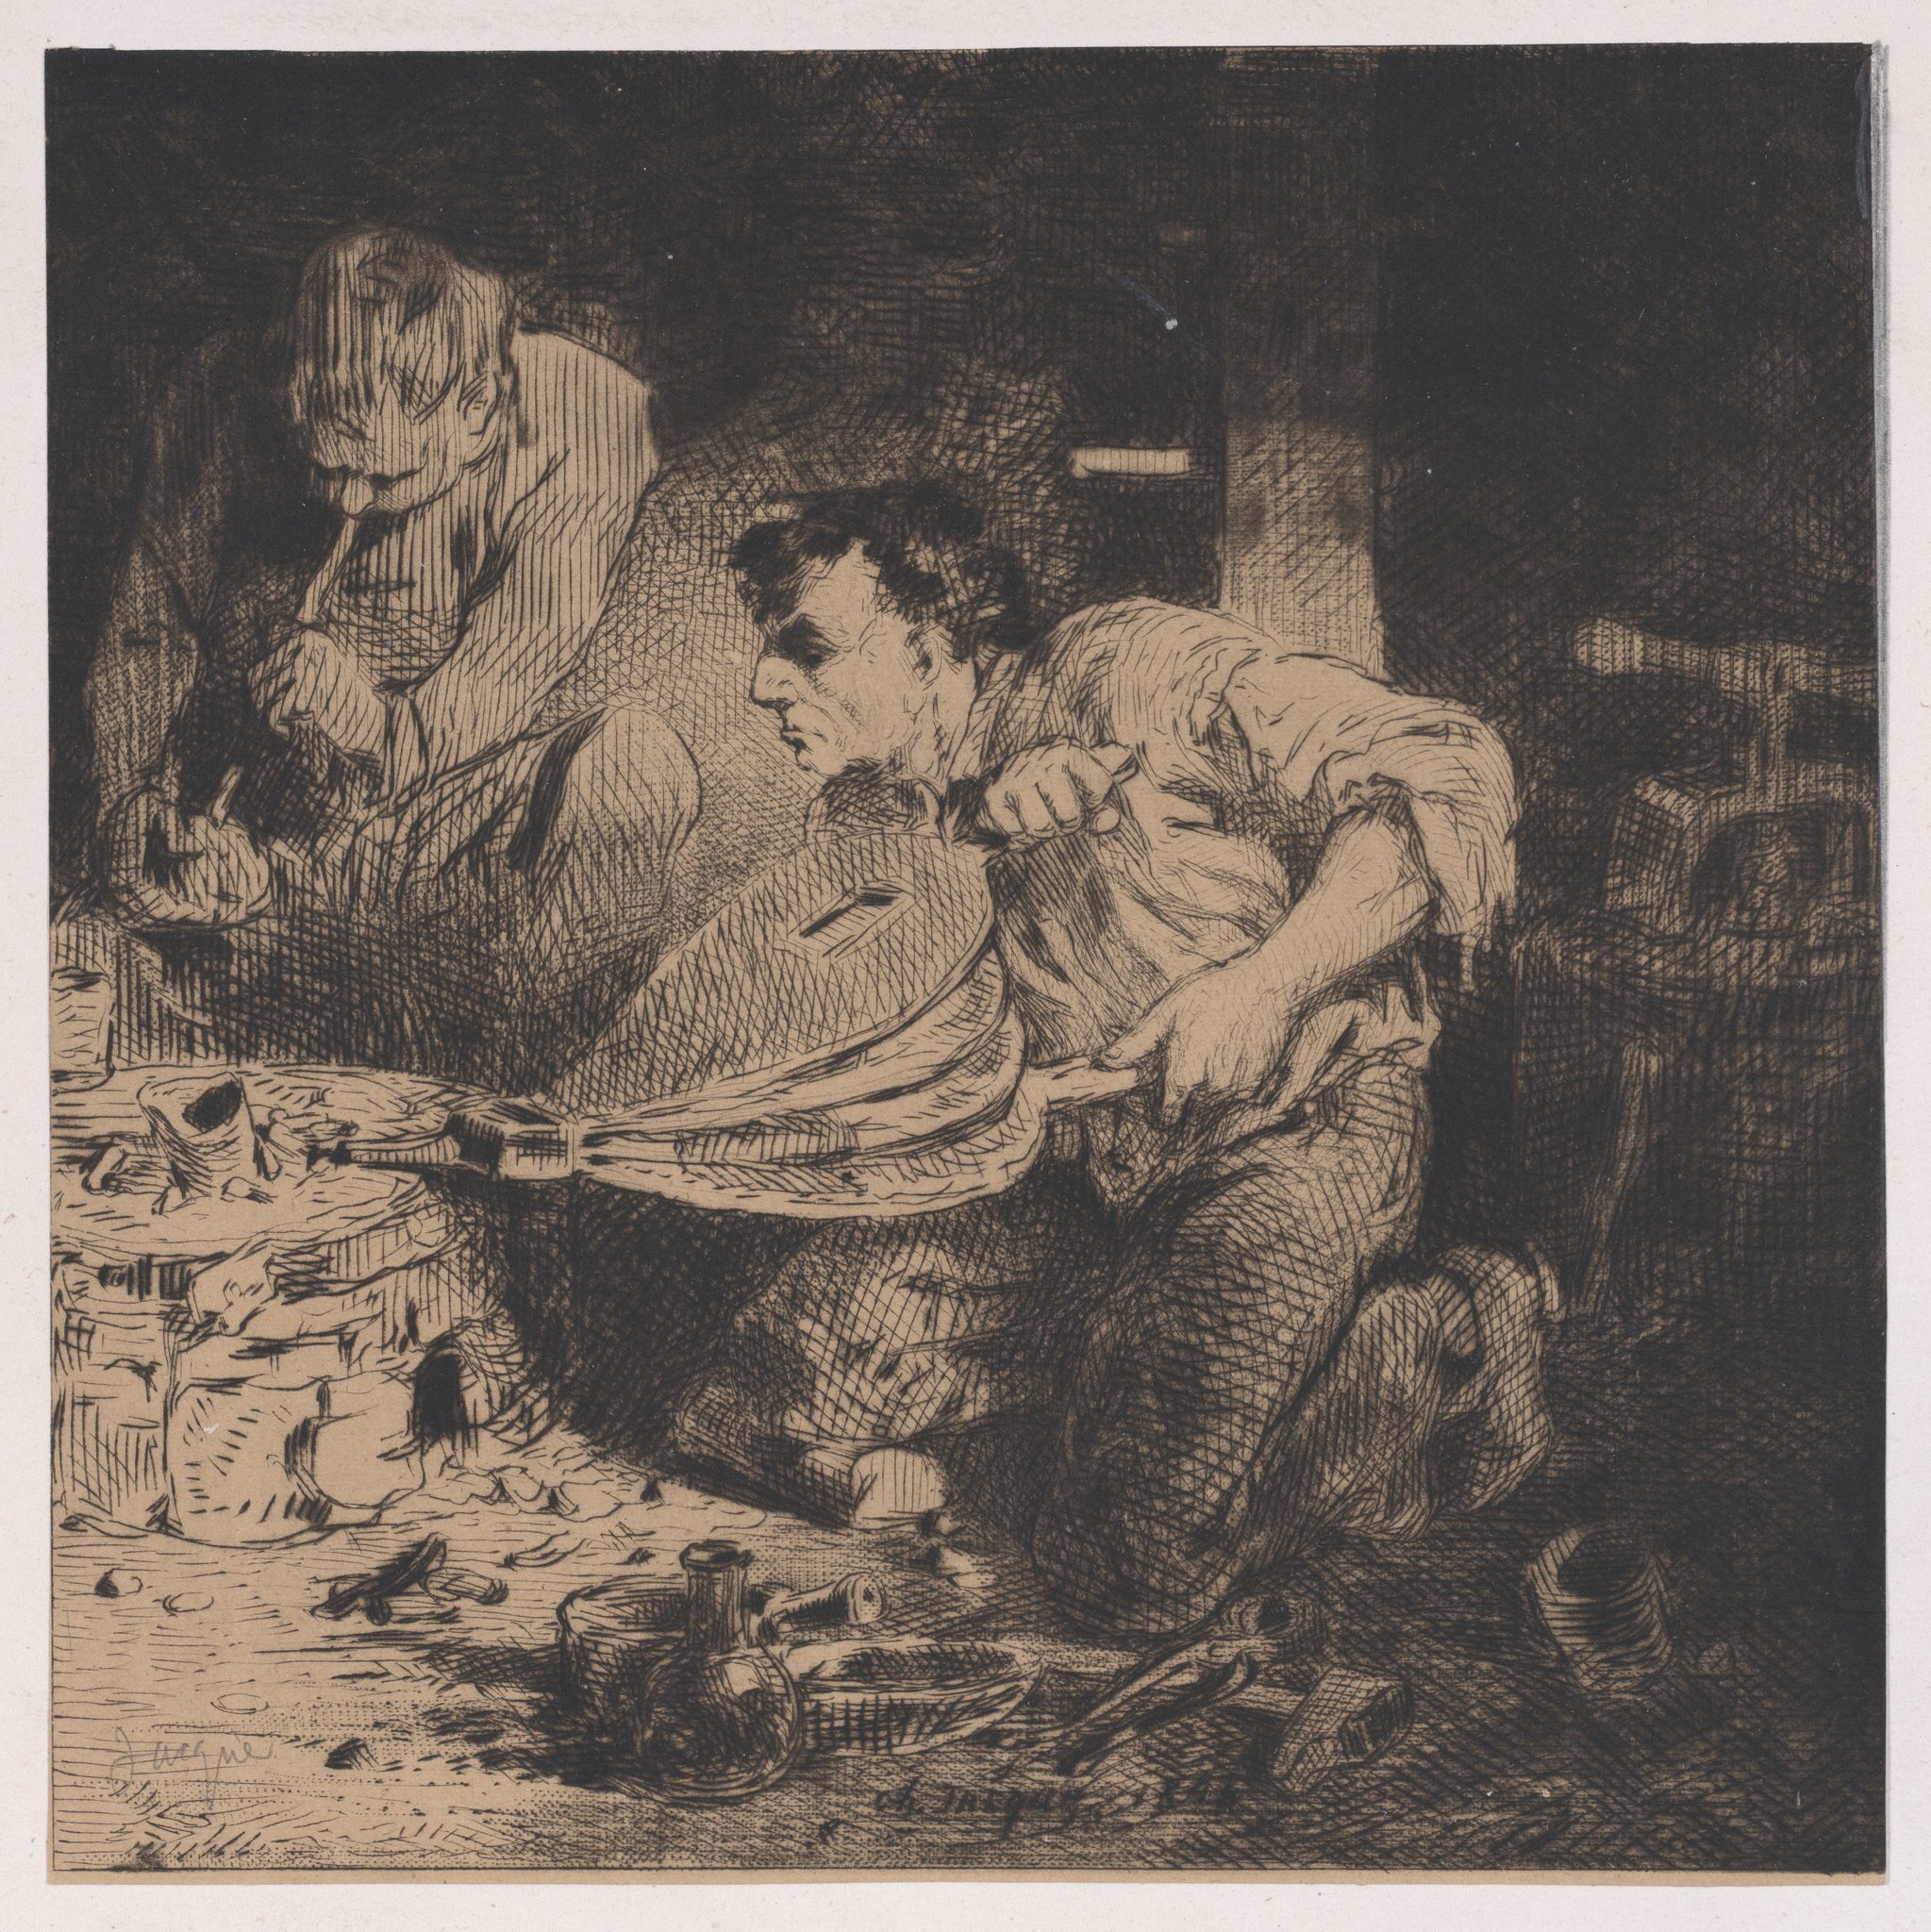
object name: print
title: The Counterfeiters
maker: charles émile jacque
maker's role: artist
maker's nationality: french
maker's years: 1813-1894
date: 1843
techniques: drypoint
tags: men,bellows